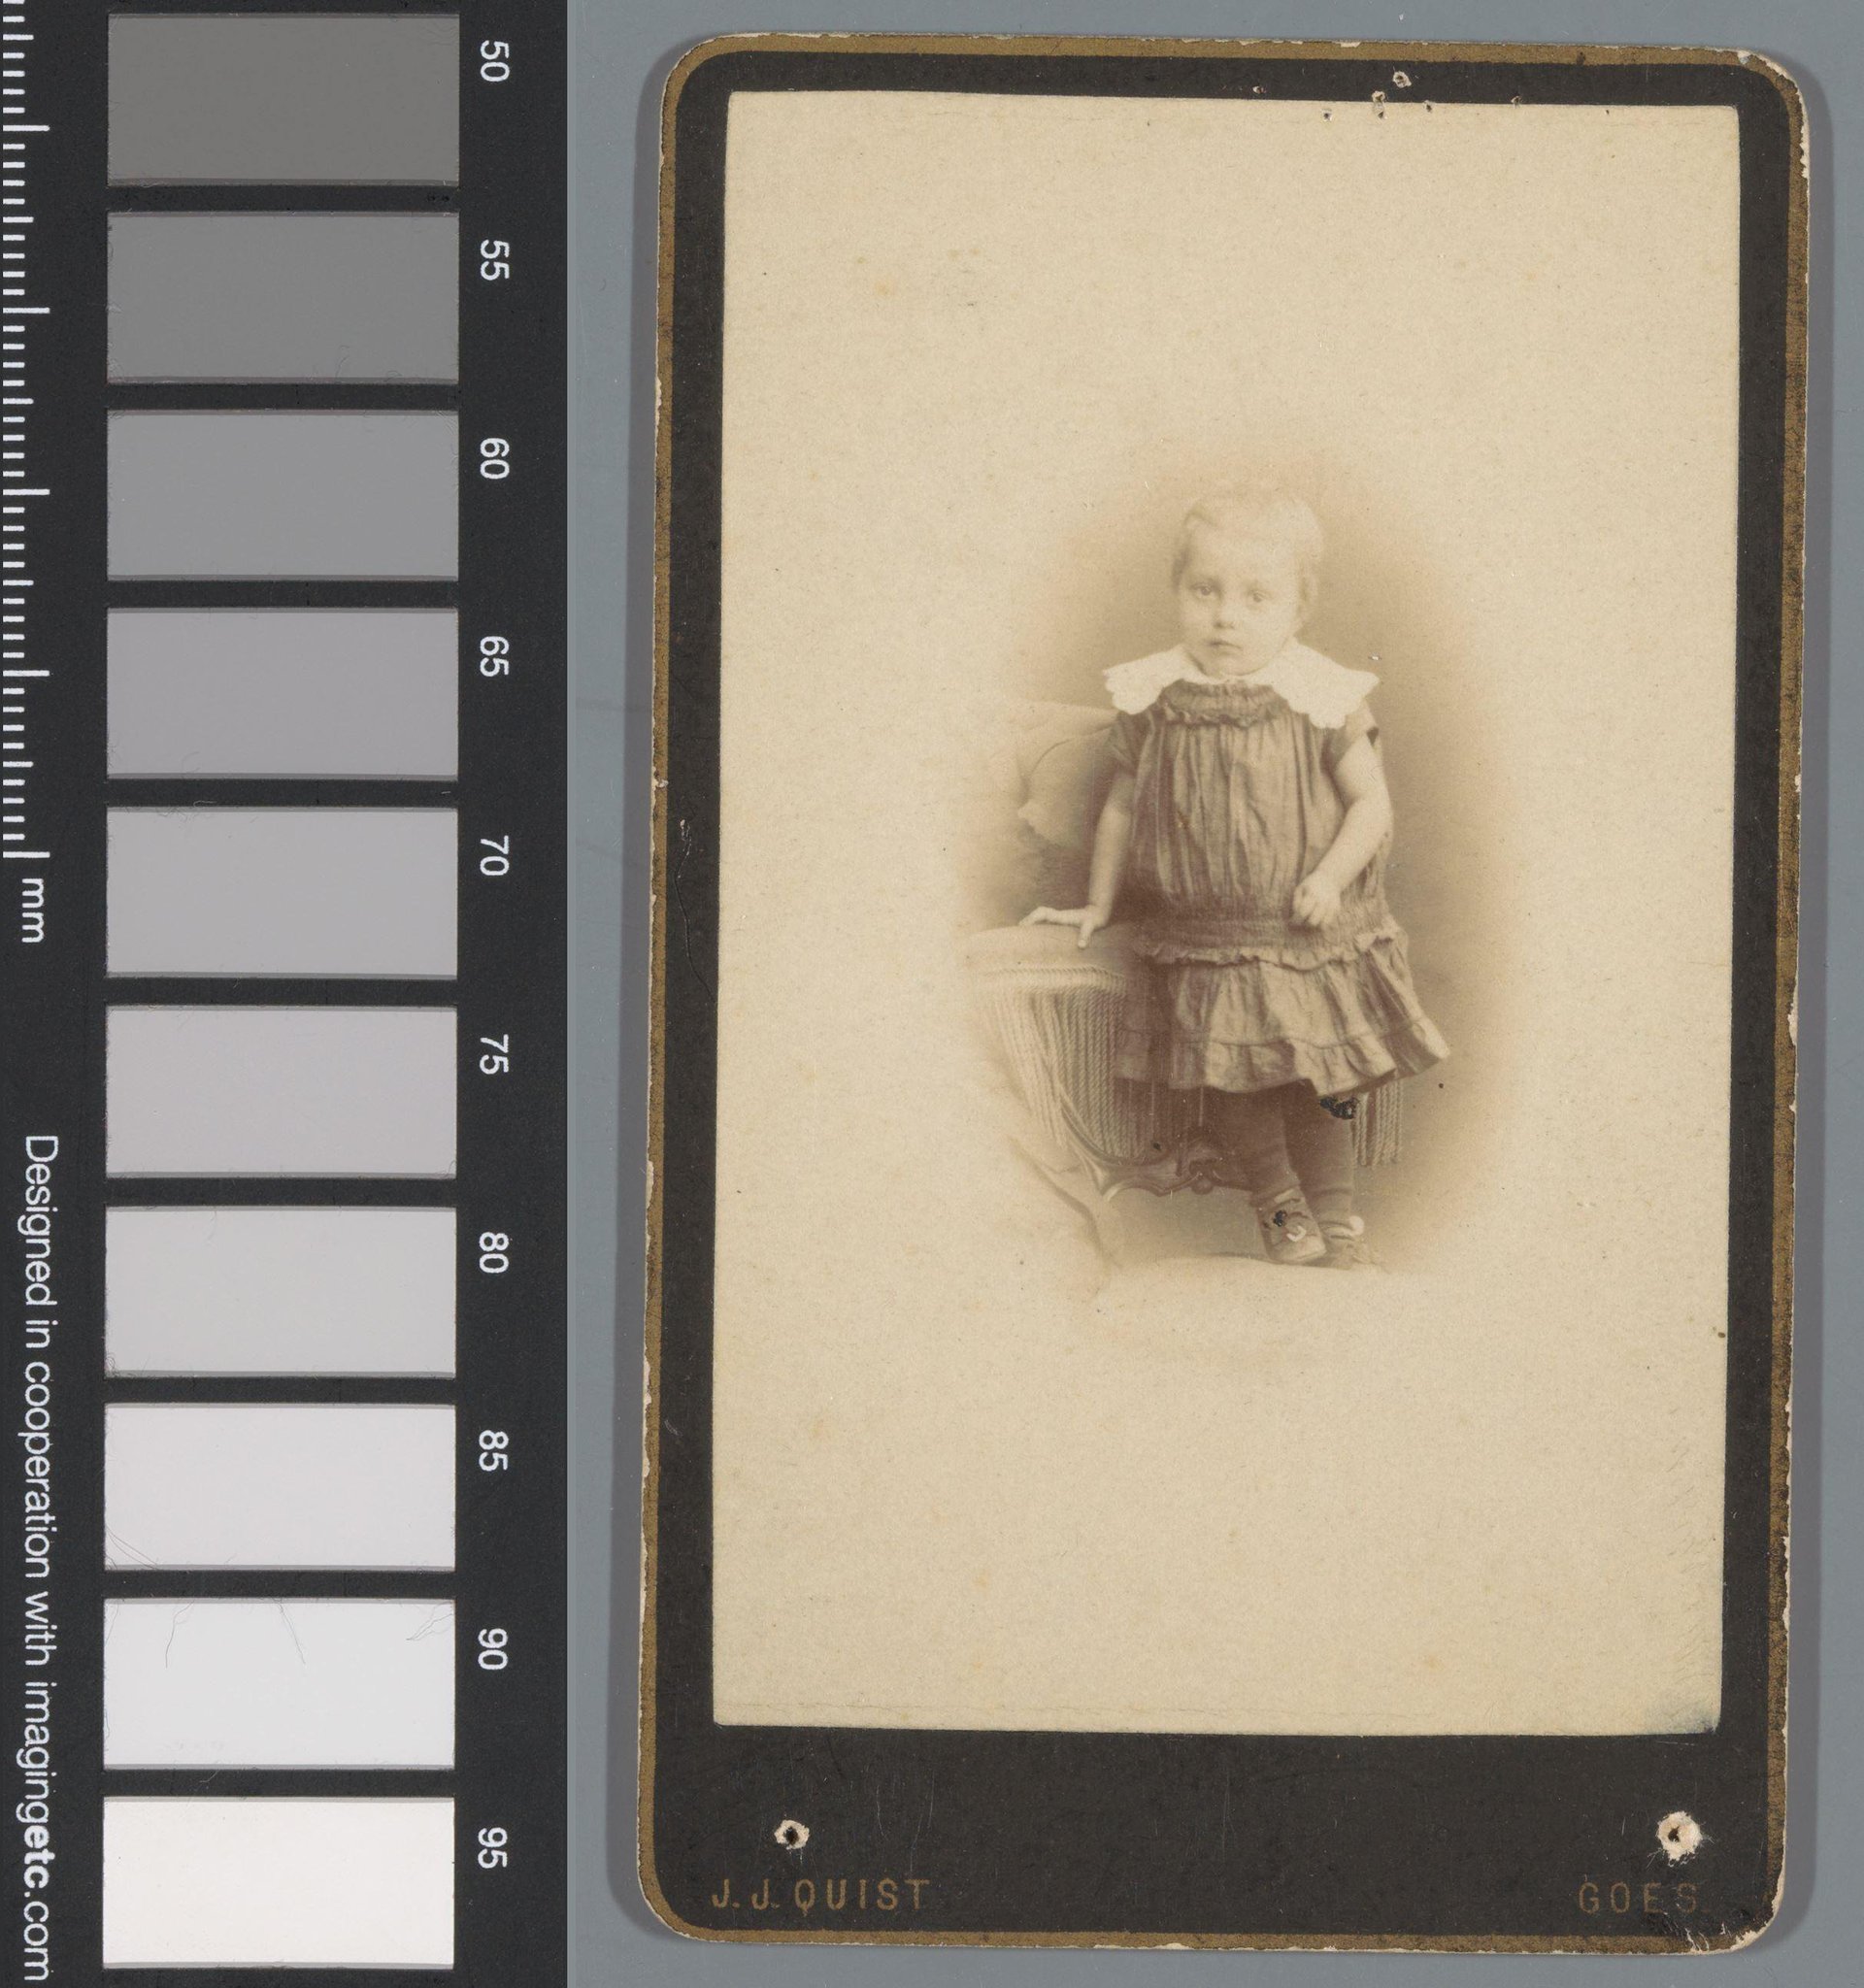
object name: carte de visite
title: Portret van een onbekend meisje, staande op een stoel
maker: j.j. quist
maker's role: fotograaf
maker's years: 1846-1918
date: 1868-1905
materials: cardboard, paper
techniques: albumen print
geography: goes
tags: historical persons, girl (child between toddler and youth), chair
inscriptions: inscription: ‘Photografisch/ ATELIER/ van/ J. J. QUIST/ GOES/ Klokstraat C. 160.’